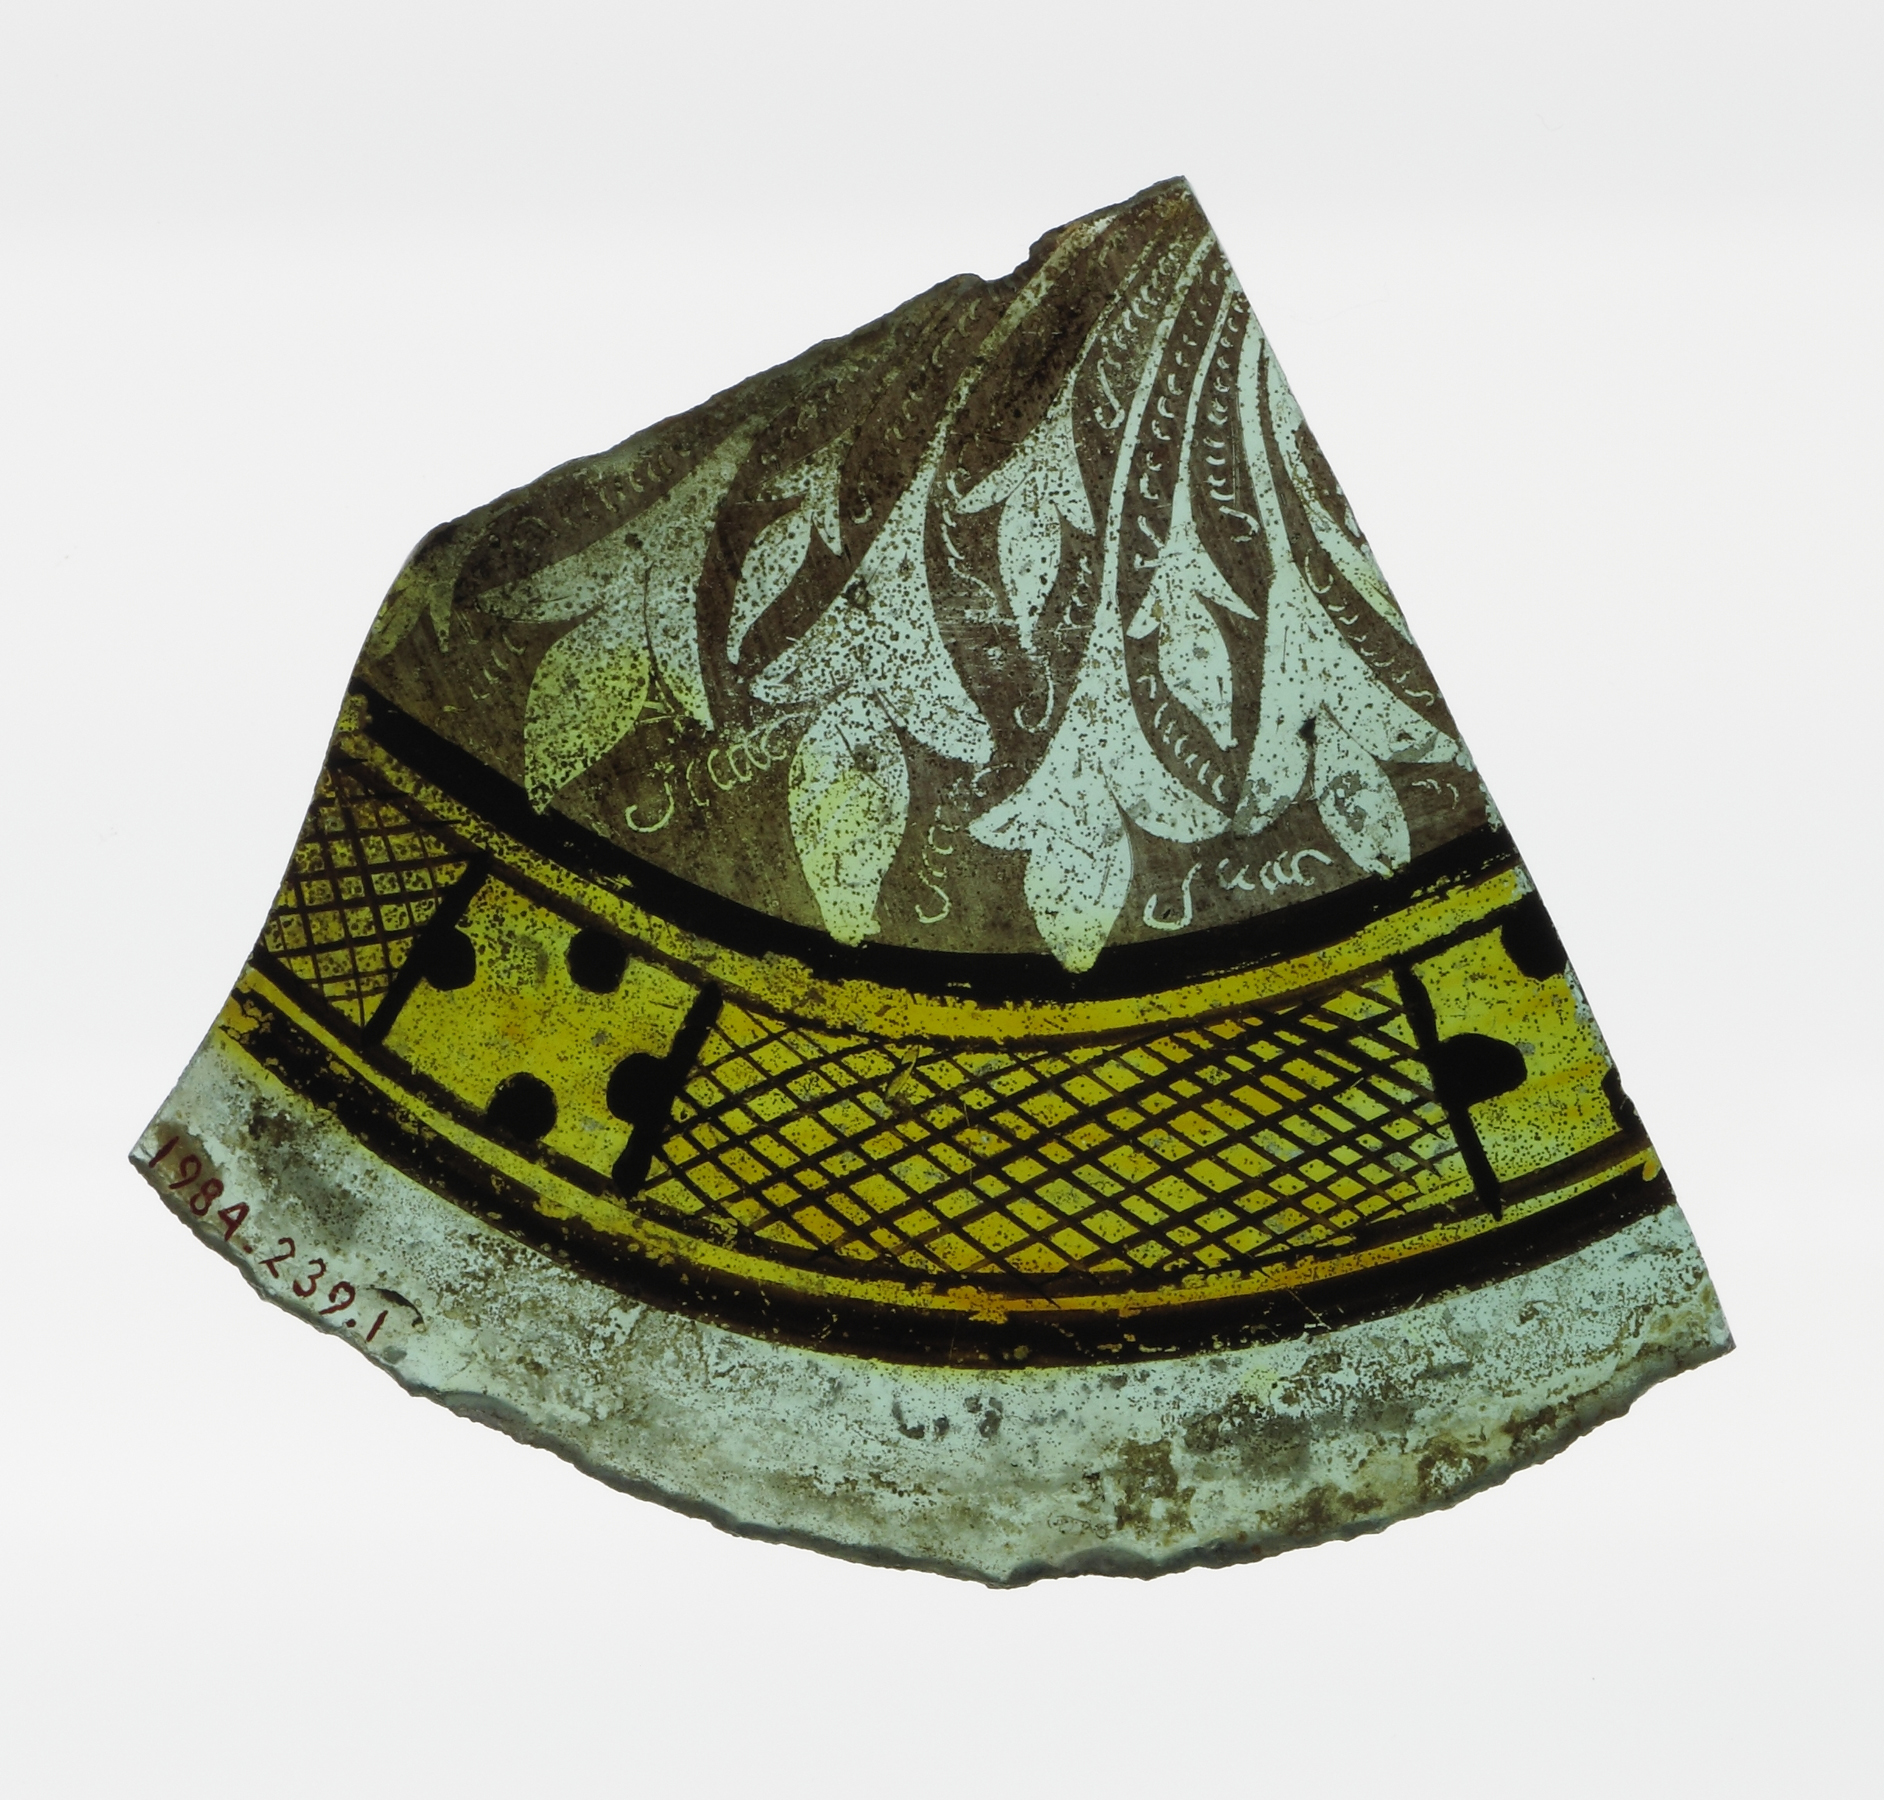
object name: fragment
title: Glass Fragment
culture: french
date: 1201-1500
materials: glass, paint, pigment